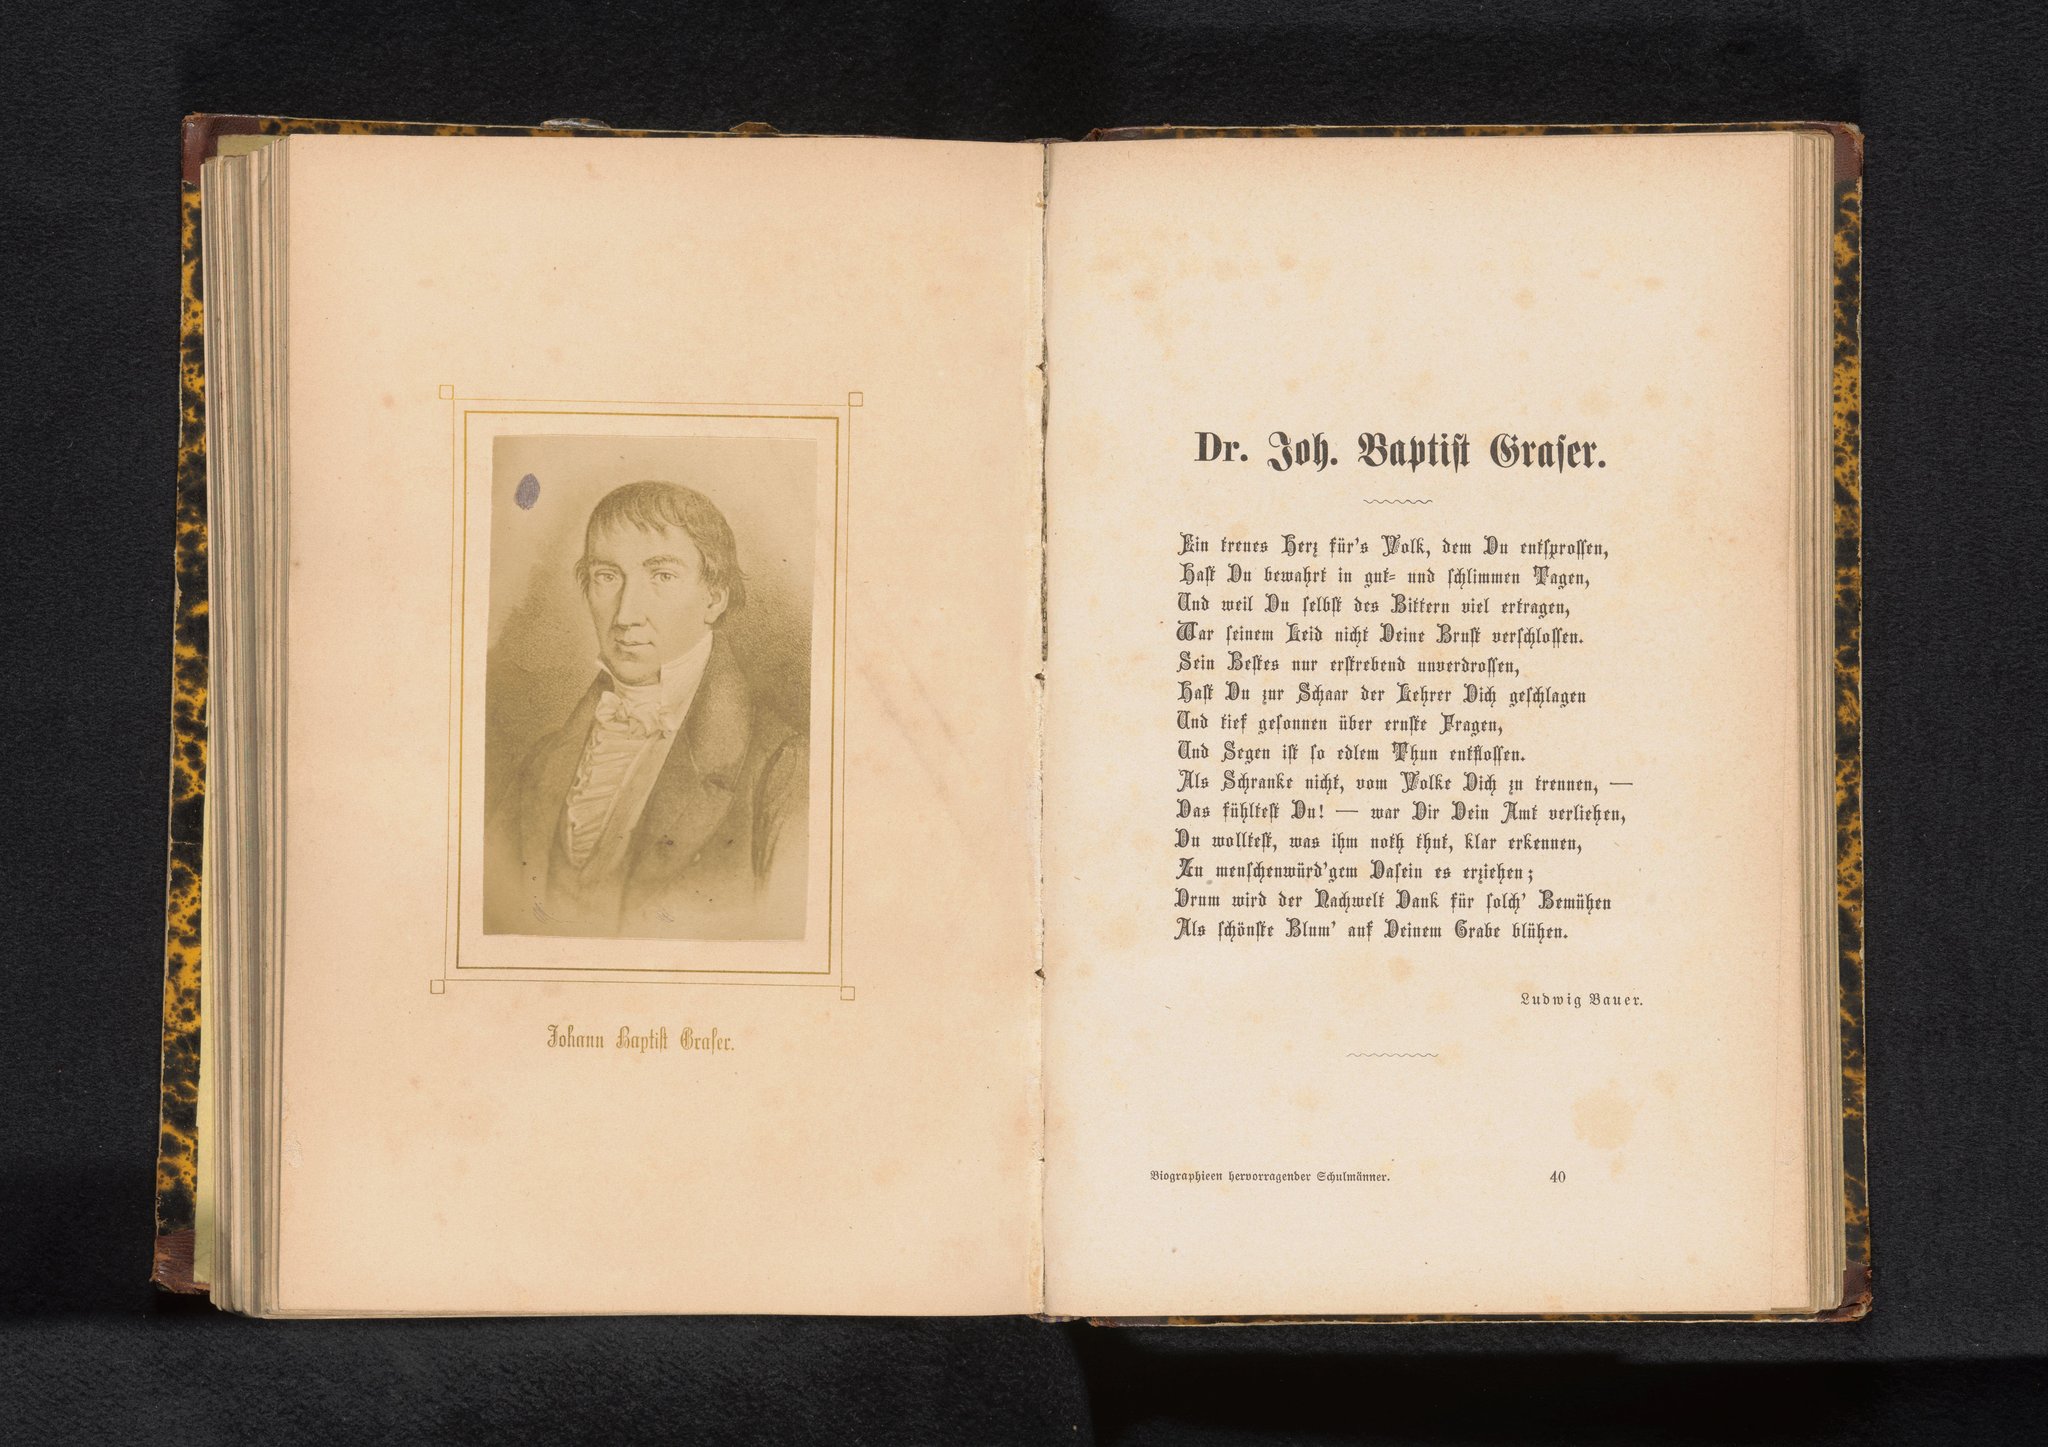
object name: page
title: Fotoreproductie van een portret van Johann Baptist Graser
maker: Anonymous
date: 1862-1872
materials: photographic support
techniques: albumen print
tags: priest, priest (roman catholic), adult man